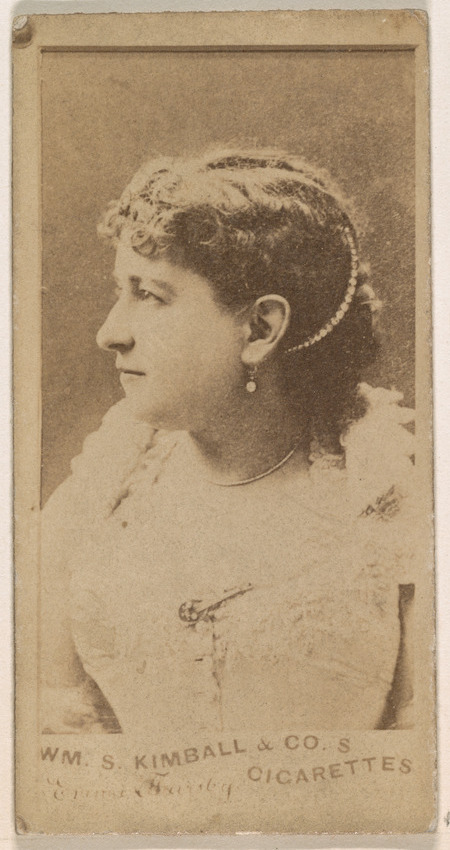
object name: photograph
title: Actress in profile, from the Actresses series (N203) issued by Wm. S. Kimball & Co.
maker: william s. kimball & company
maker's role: publisher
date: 1889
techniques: color lithograph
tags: women,actresses